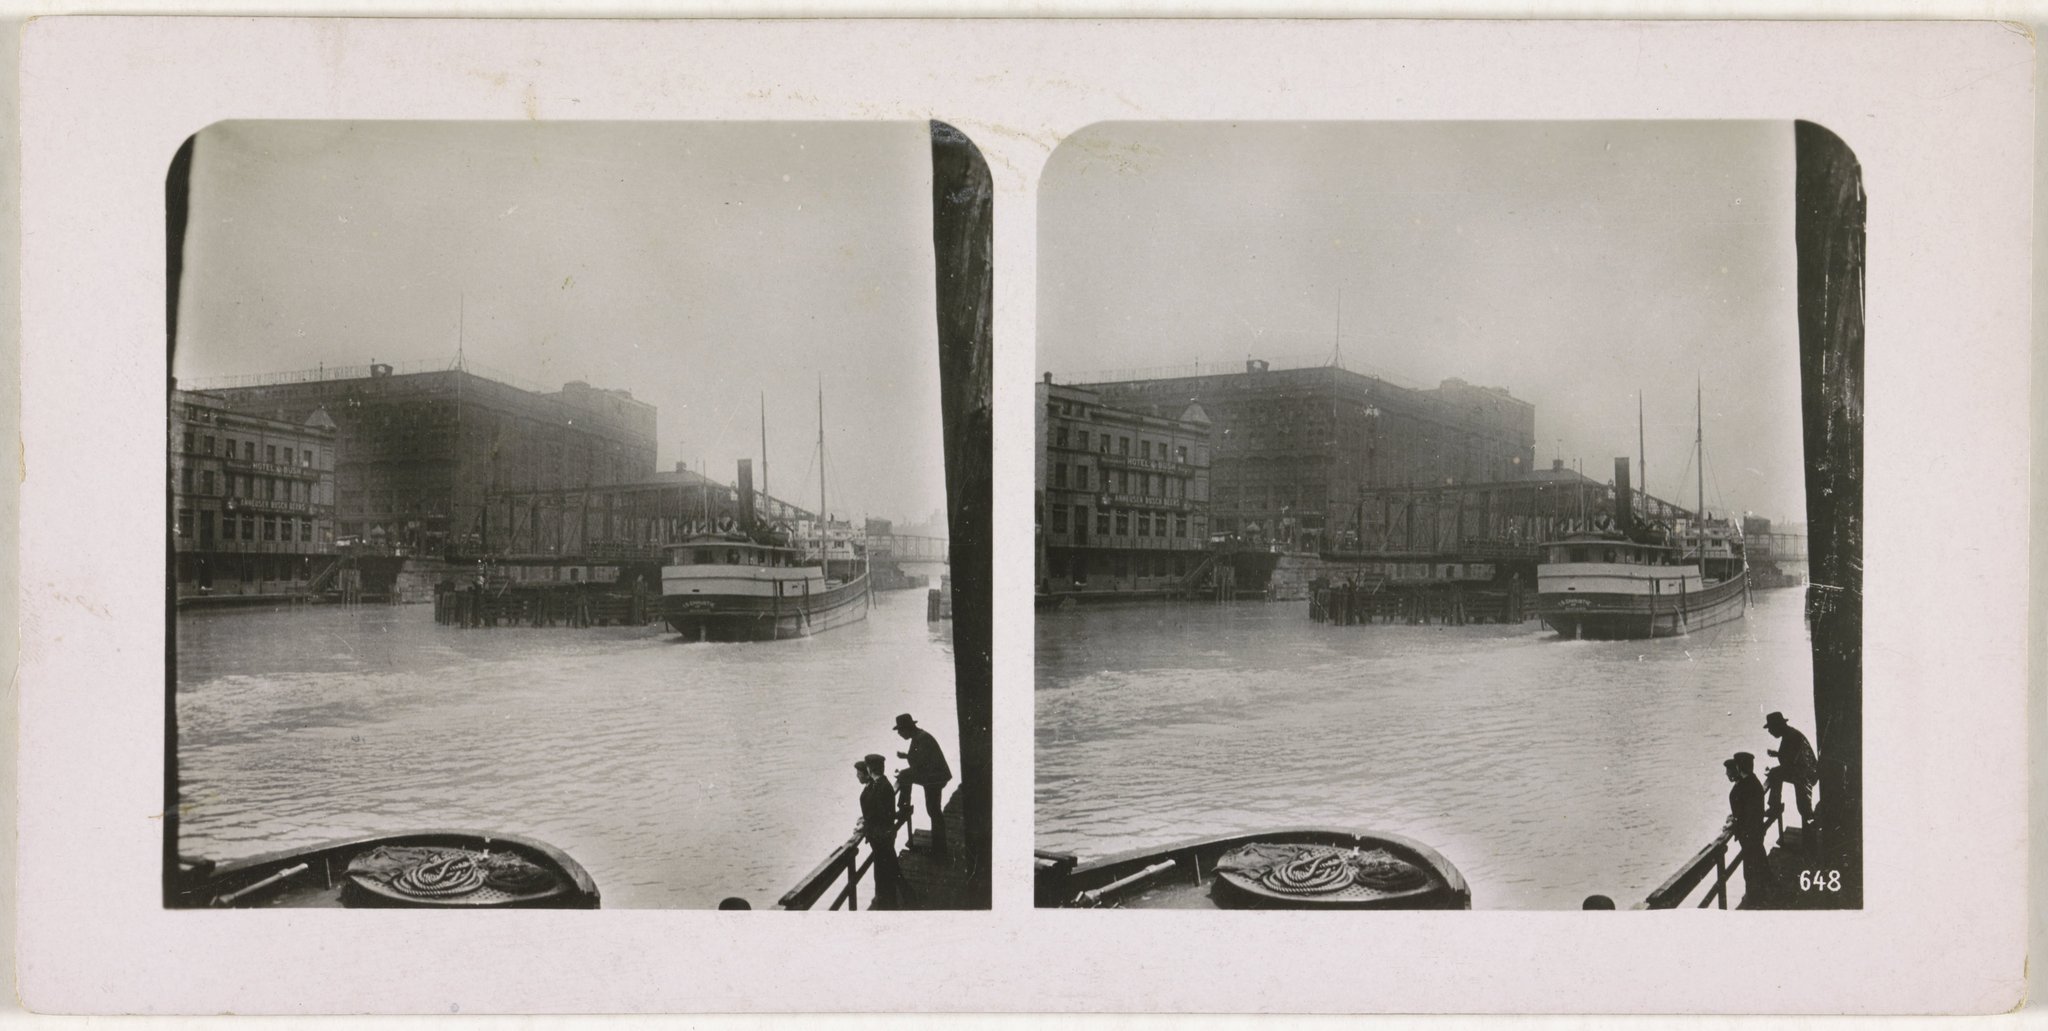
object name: stereograph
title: Gezicht op de haven van Chicago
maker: Anonymous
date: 1884-1914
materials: cardboard, paper, photographic support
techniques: gelatin silver print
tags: chicago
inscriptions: label: ‘648. Im Hafen von Chicago. / In the harbor of Chicago...’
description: Rechtsonder op de foto rechts staat: 648.